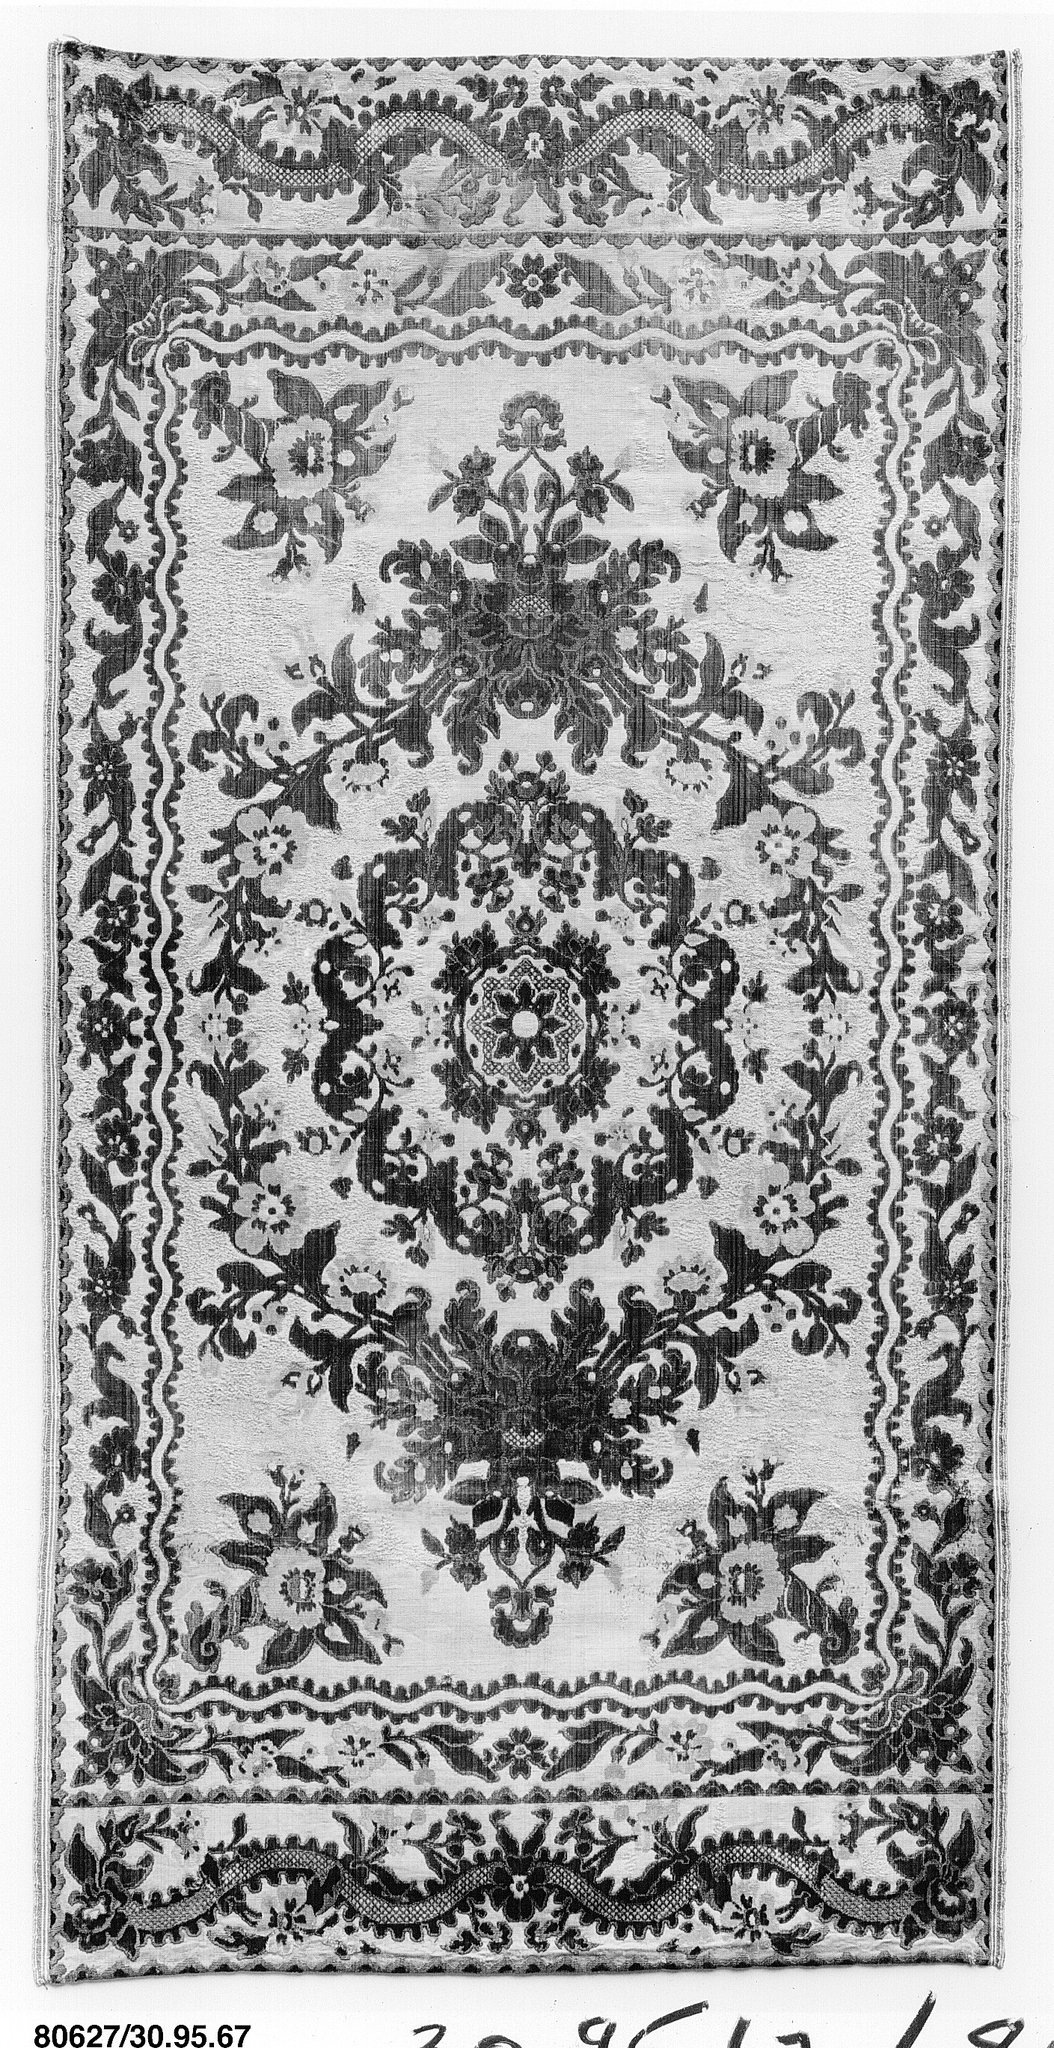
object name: piece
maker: albergo di virtù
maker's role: manufactory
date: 1701-1800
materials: silk, silver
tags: flowers